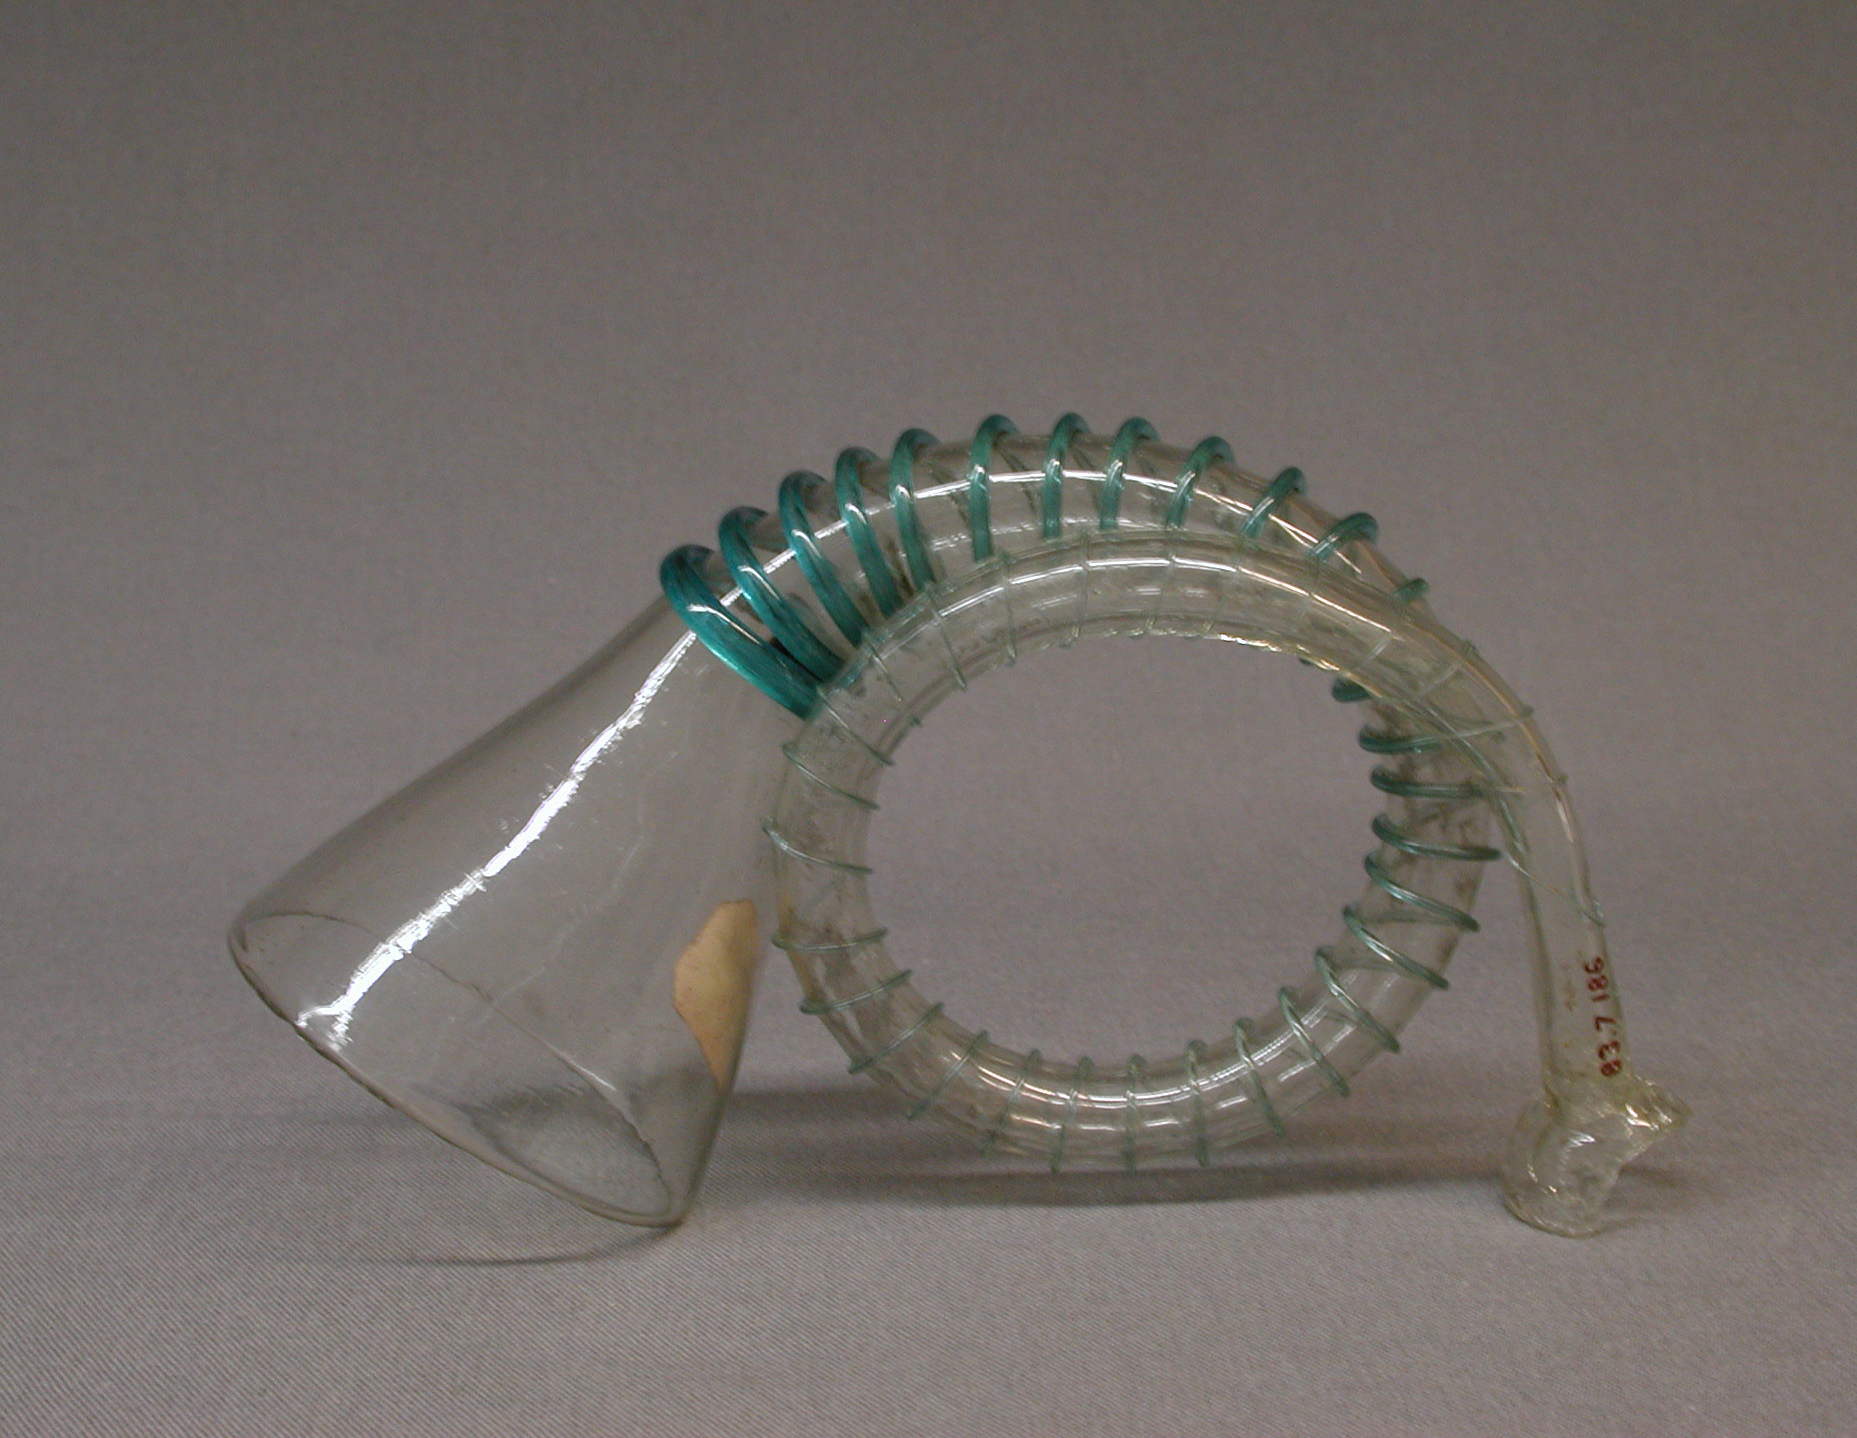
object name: horn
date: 1801-1900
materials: glass